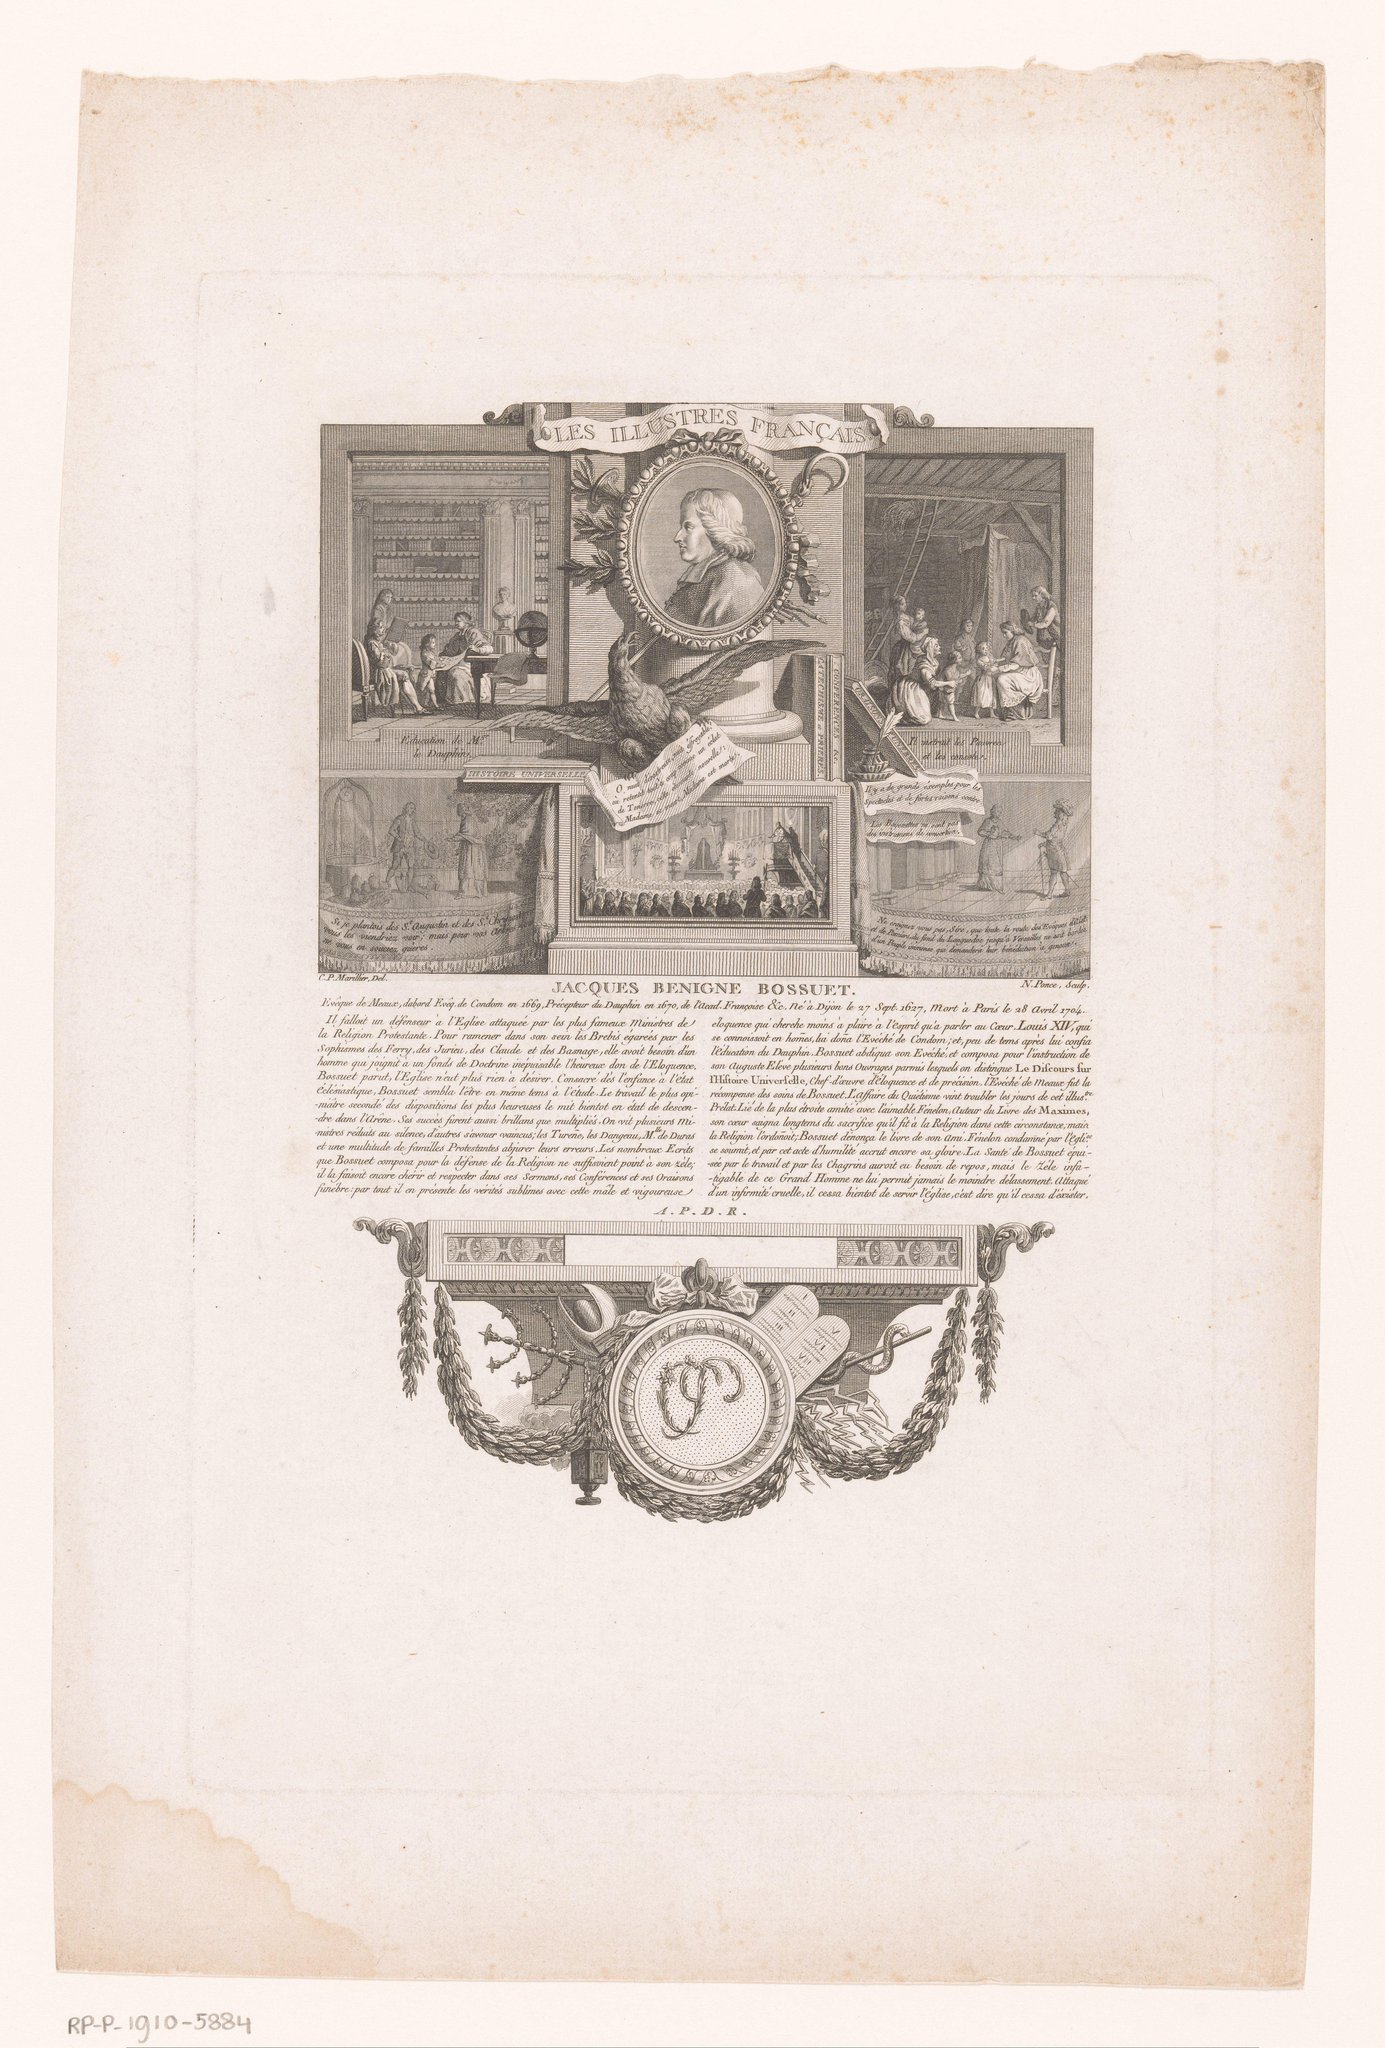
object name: print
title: Les illustres français, ou tableaux historiques des grands hommes de la France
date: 1790-1816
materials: paper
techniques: engraving, etching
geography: france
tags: paris, archbishop, bishop, etc. (roman catholic), historical persons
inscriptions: collector's mark: Lugt 2228